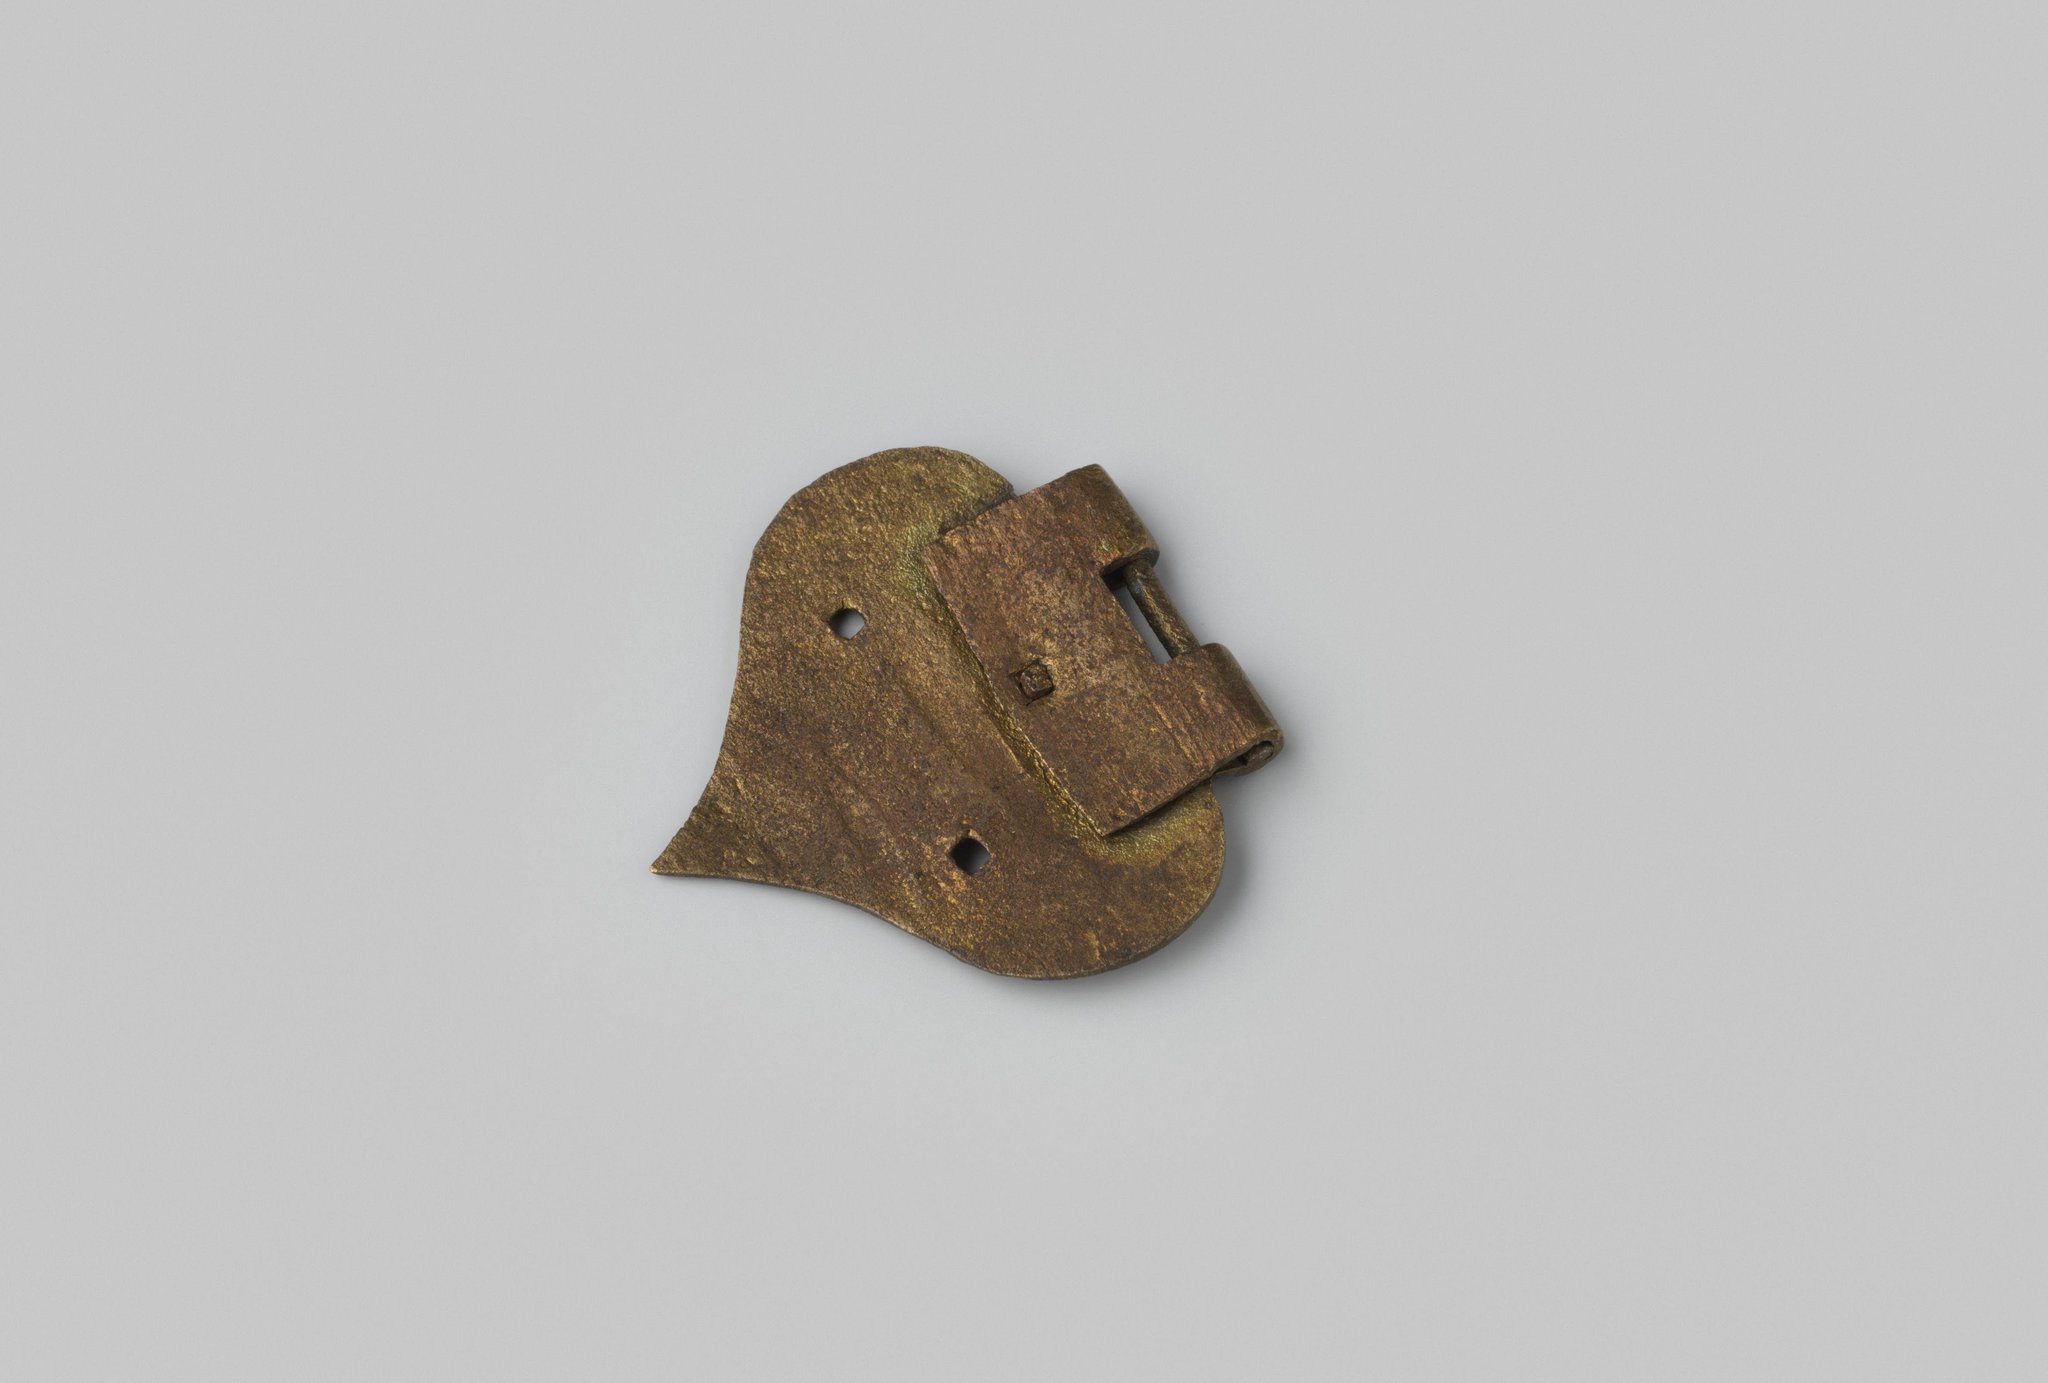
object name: scharnier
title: Scharnier uit het wrak van de Oost-Indiëvaarder Hollandia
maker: Anonymous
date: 1700-1743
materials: copper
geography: netherlands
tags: verenigde oostindische compagnie, hollandia (schip), annet